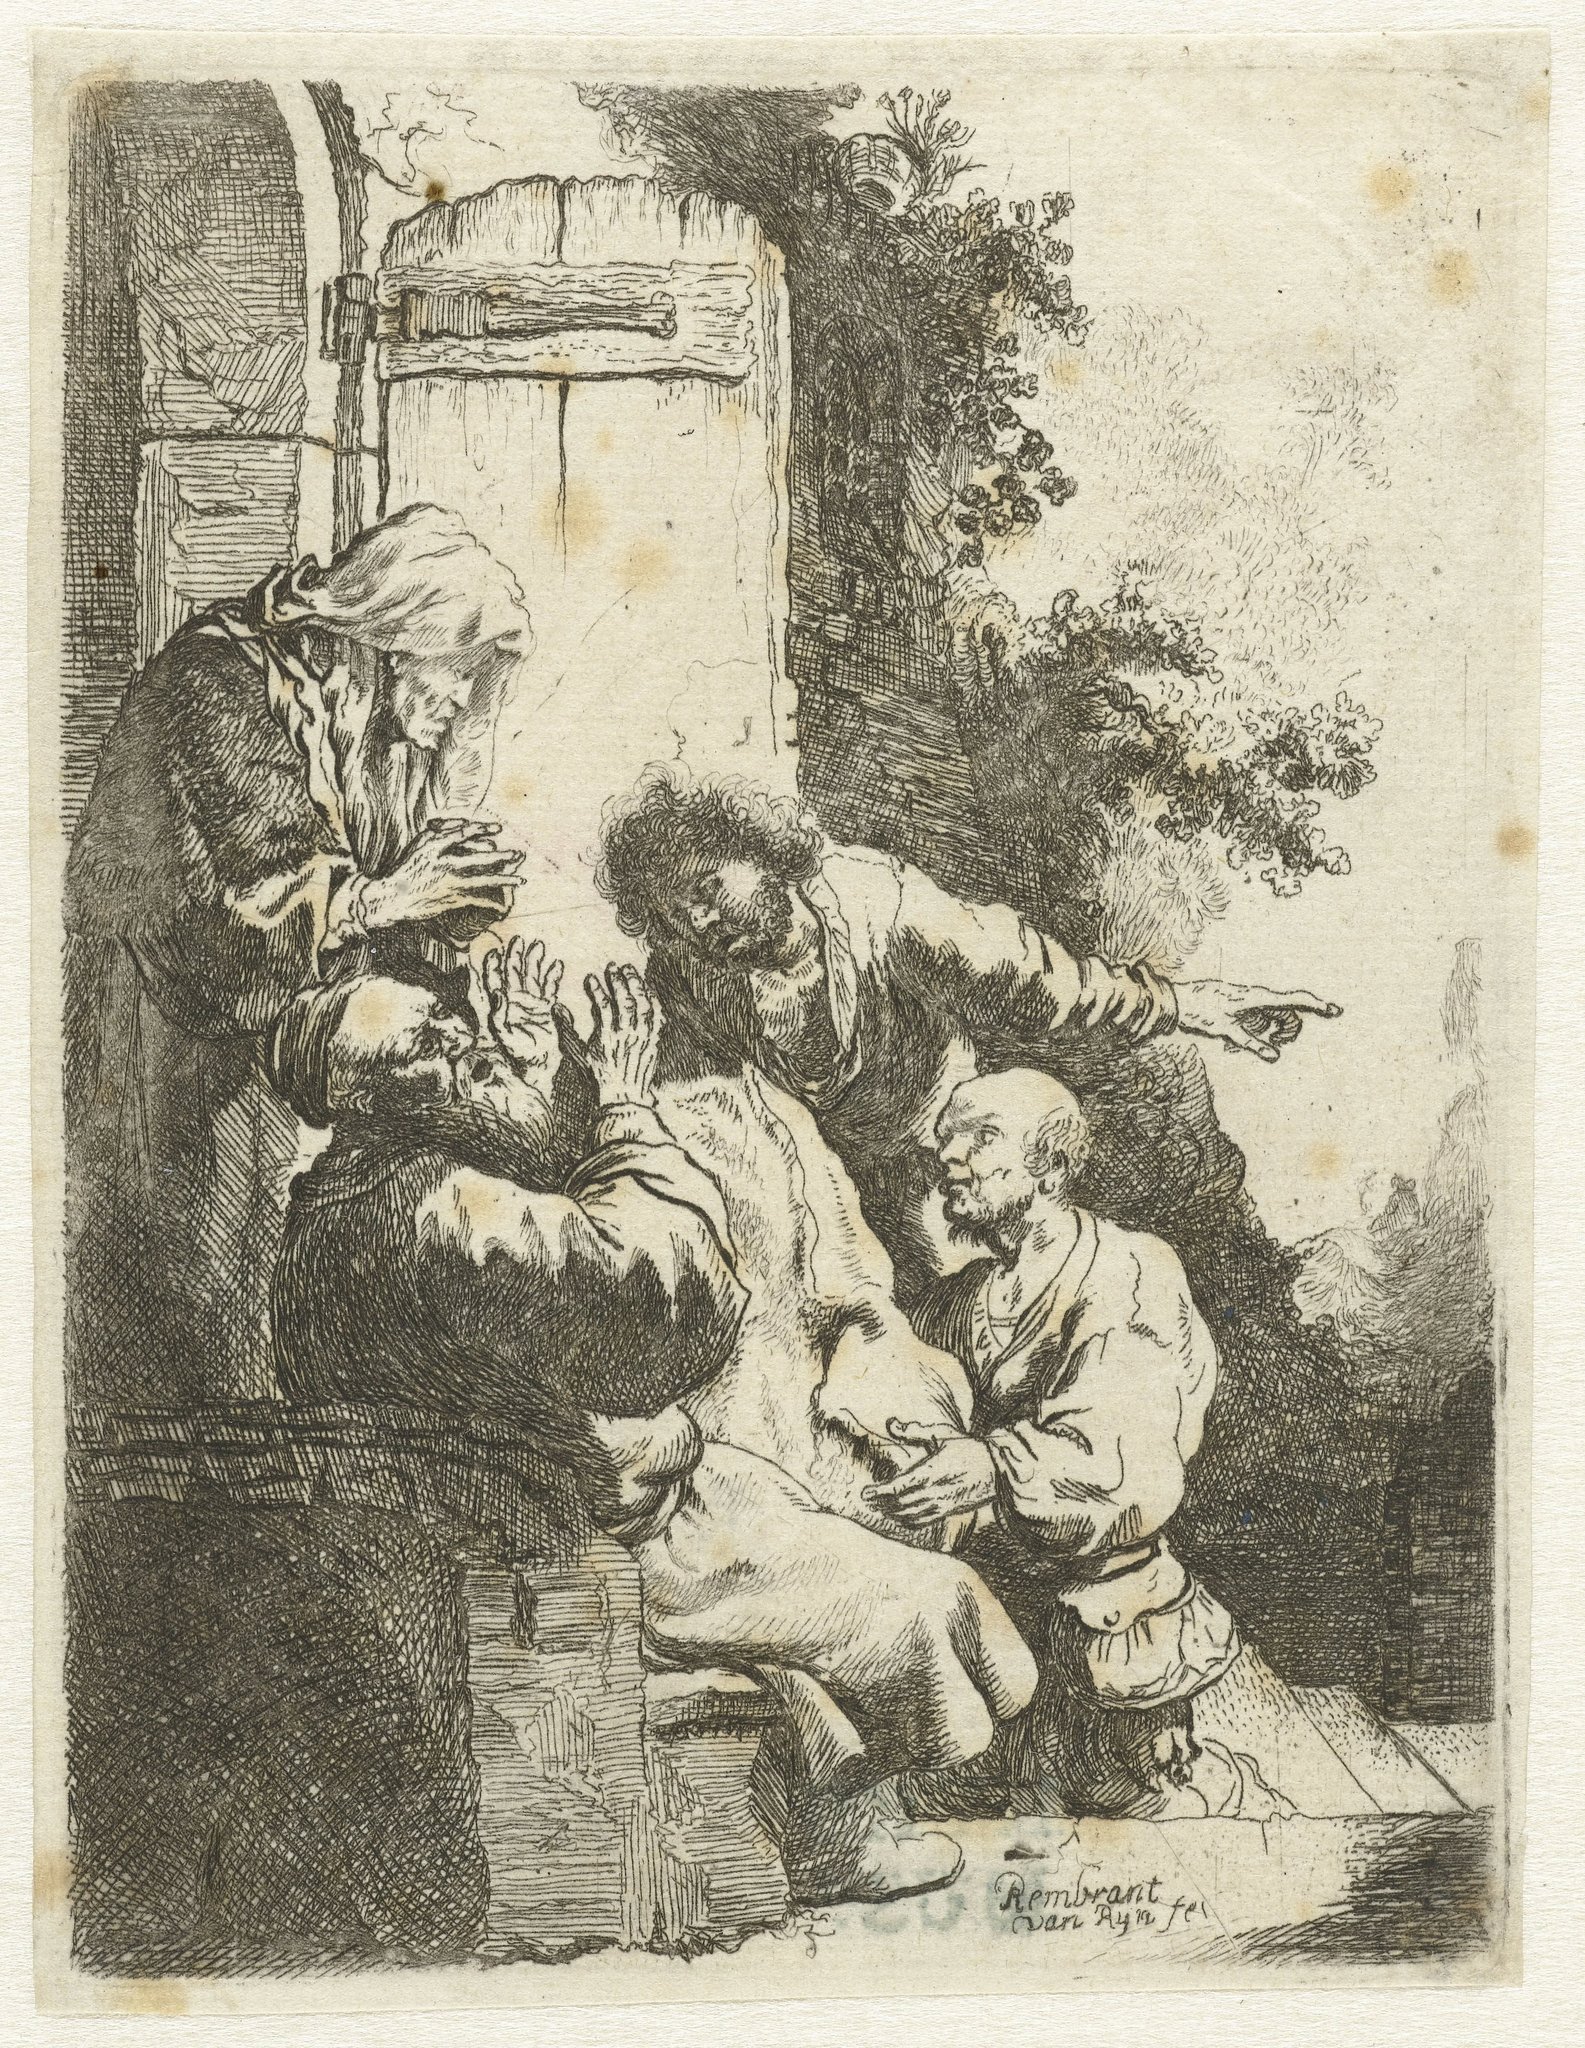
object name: print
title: Joseph's coat brought to Jacob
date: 1633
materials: paper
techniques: etching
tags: genesis: the story of joseph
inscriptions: collector's mark: Lugt 2166